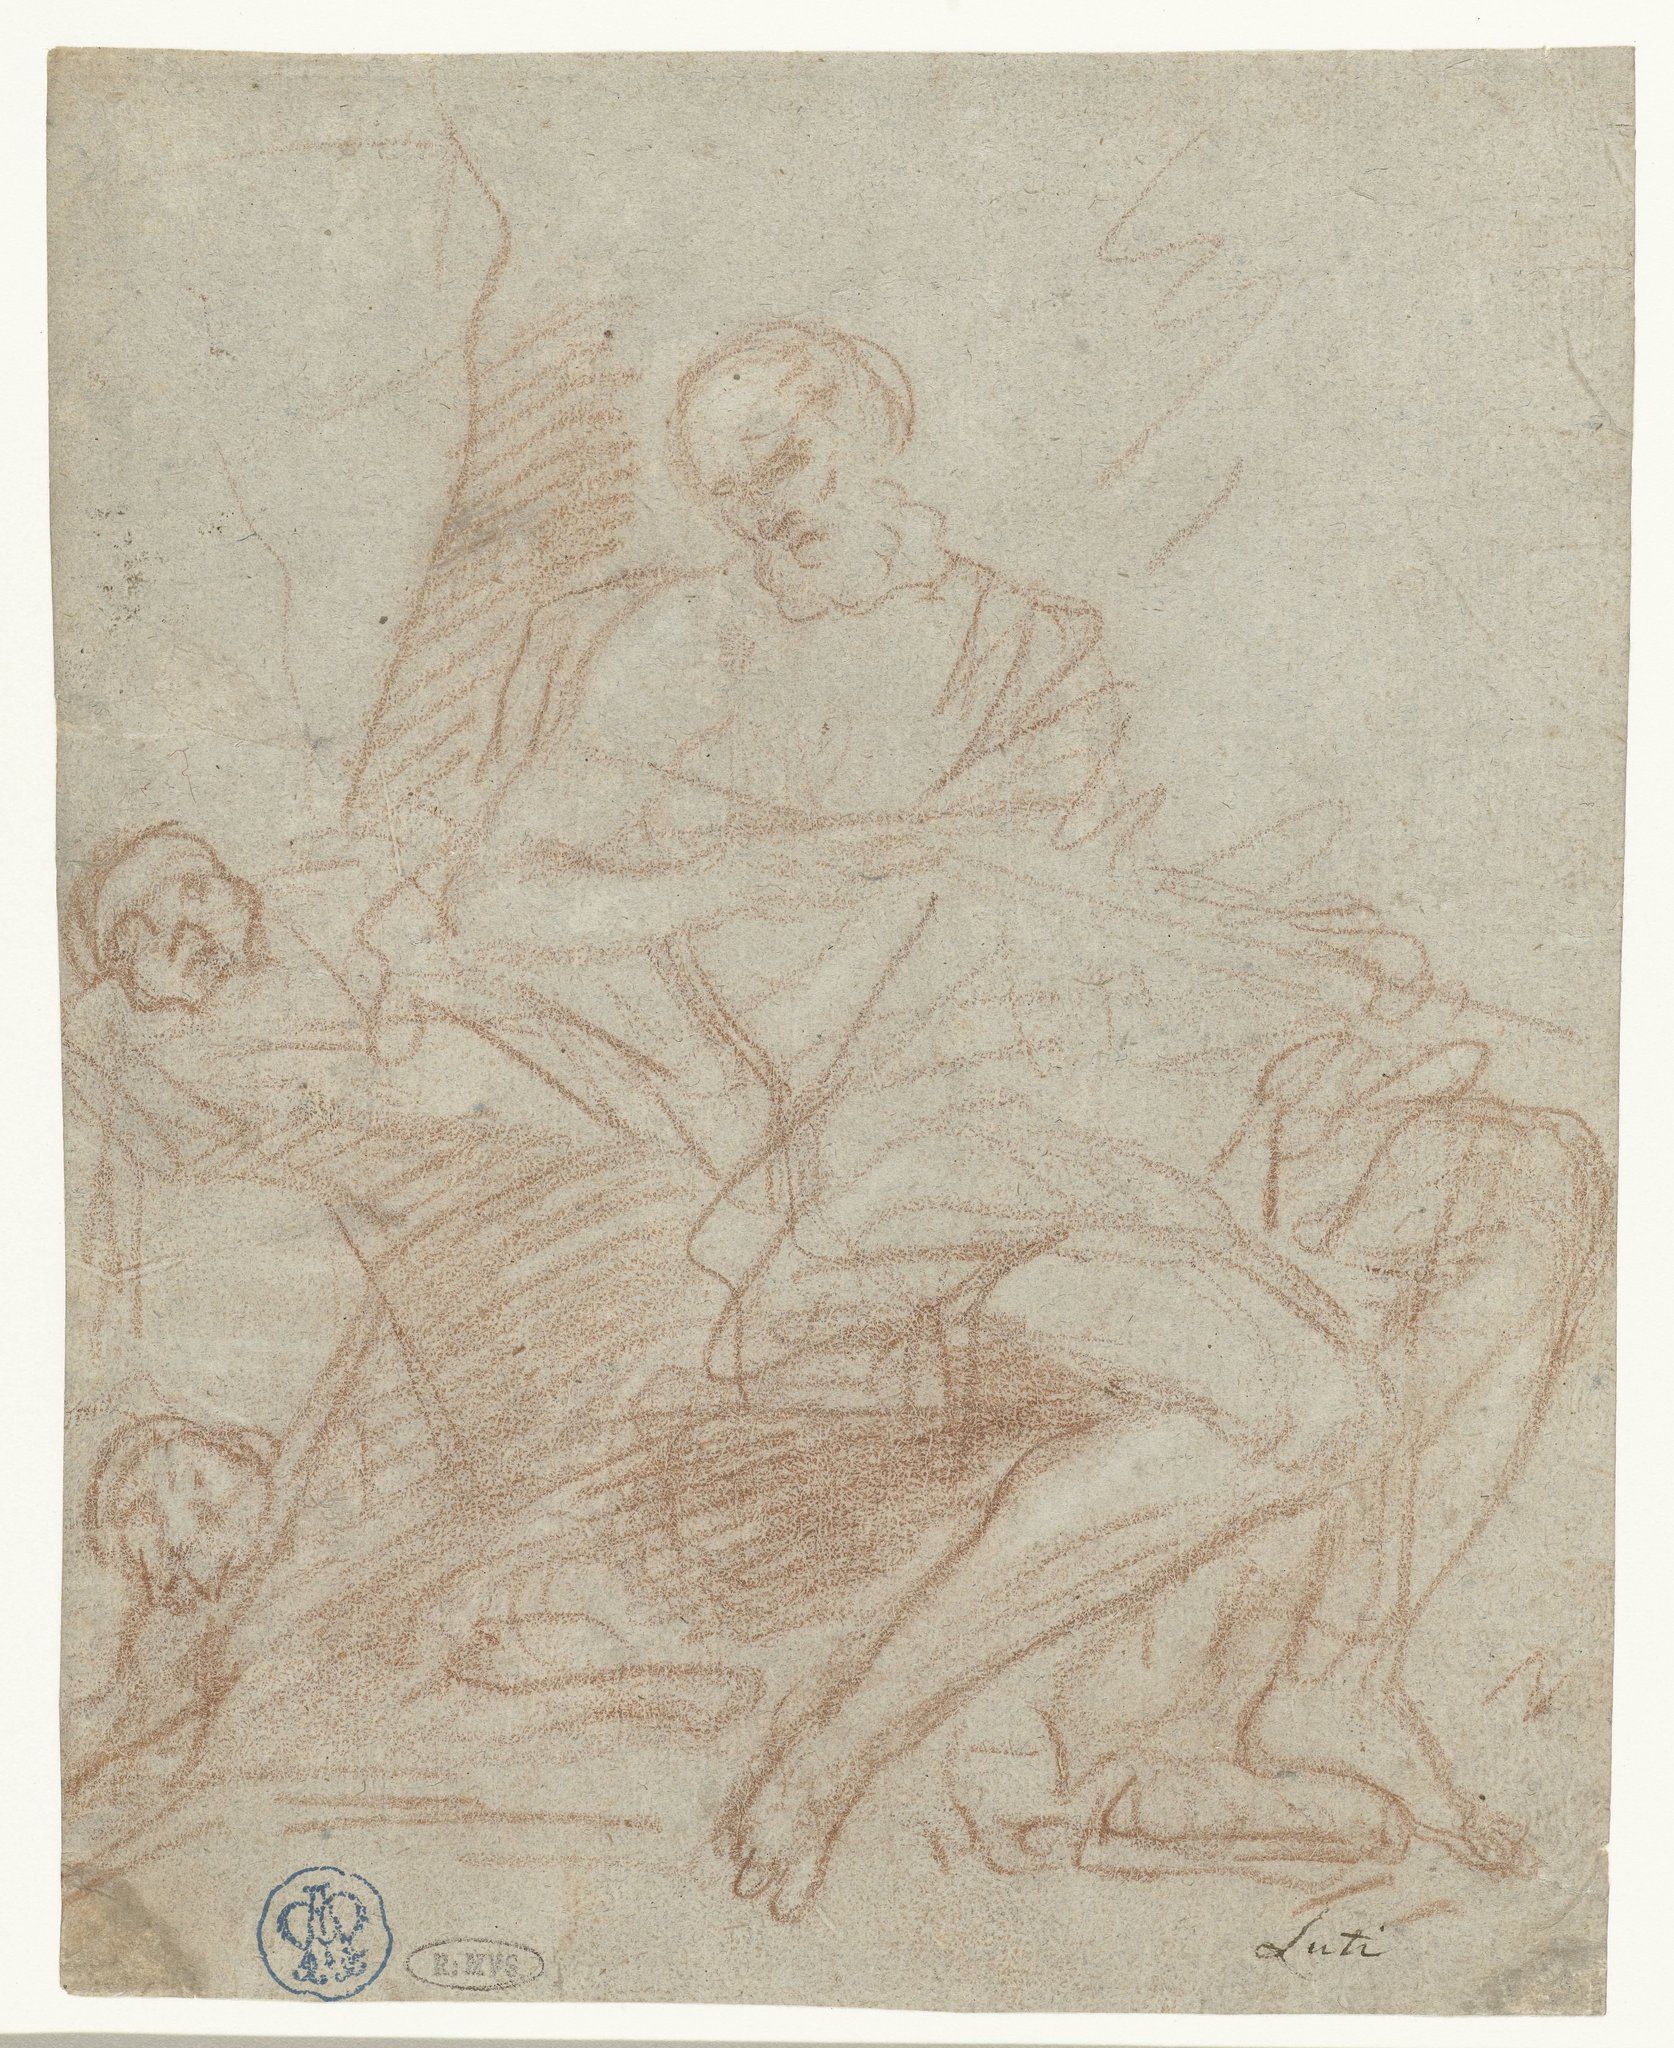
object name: drawing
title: De heilige Hieronymus, als kluizenaar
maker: benedetto luti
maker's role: draughtsman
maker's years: 1666-1724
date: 1676-1724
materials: chalk, paper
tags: the monk and hermit jerome (hieronymus); possible attributes: book, cardinal's hat, crucifix, hour-glass, lion, skull, stone